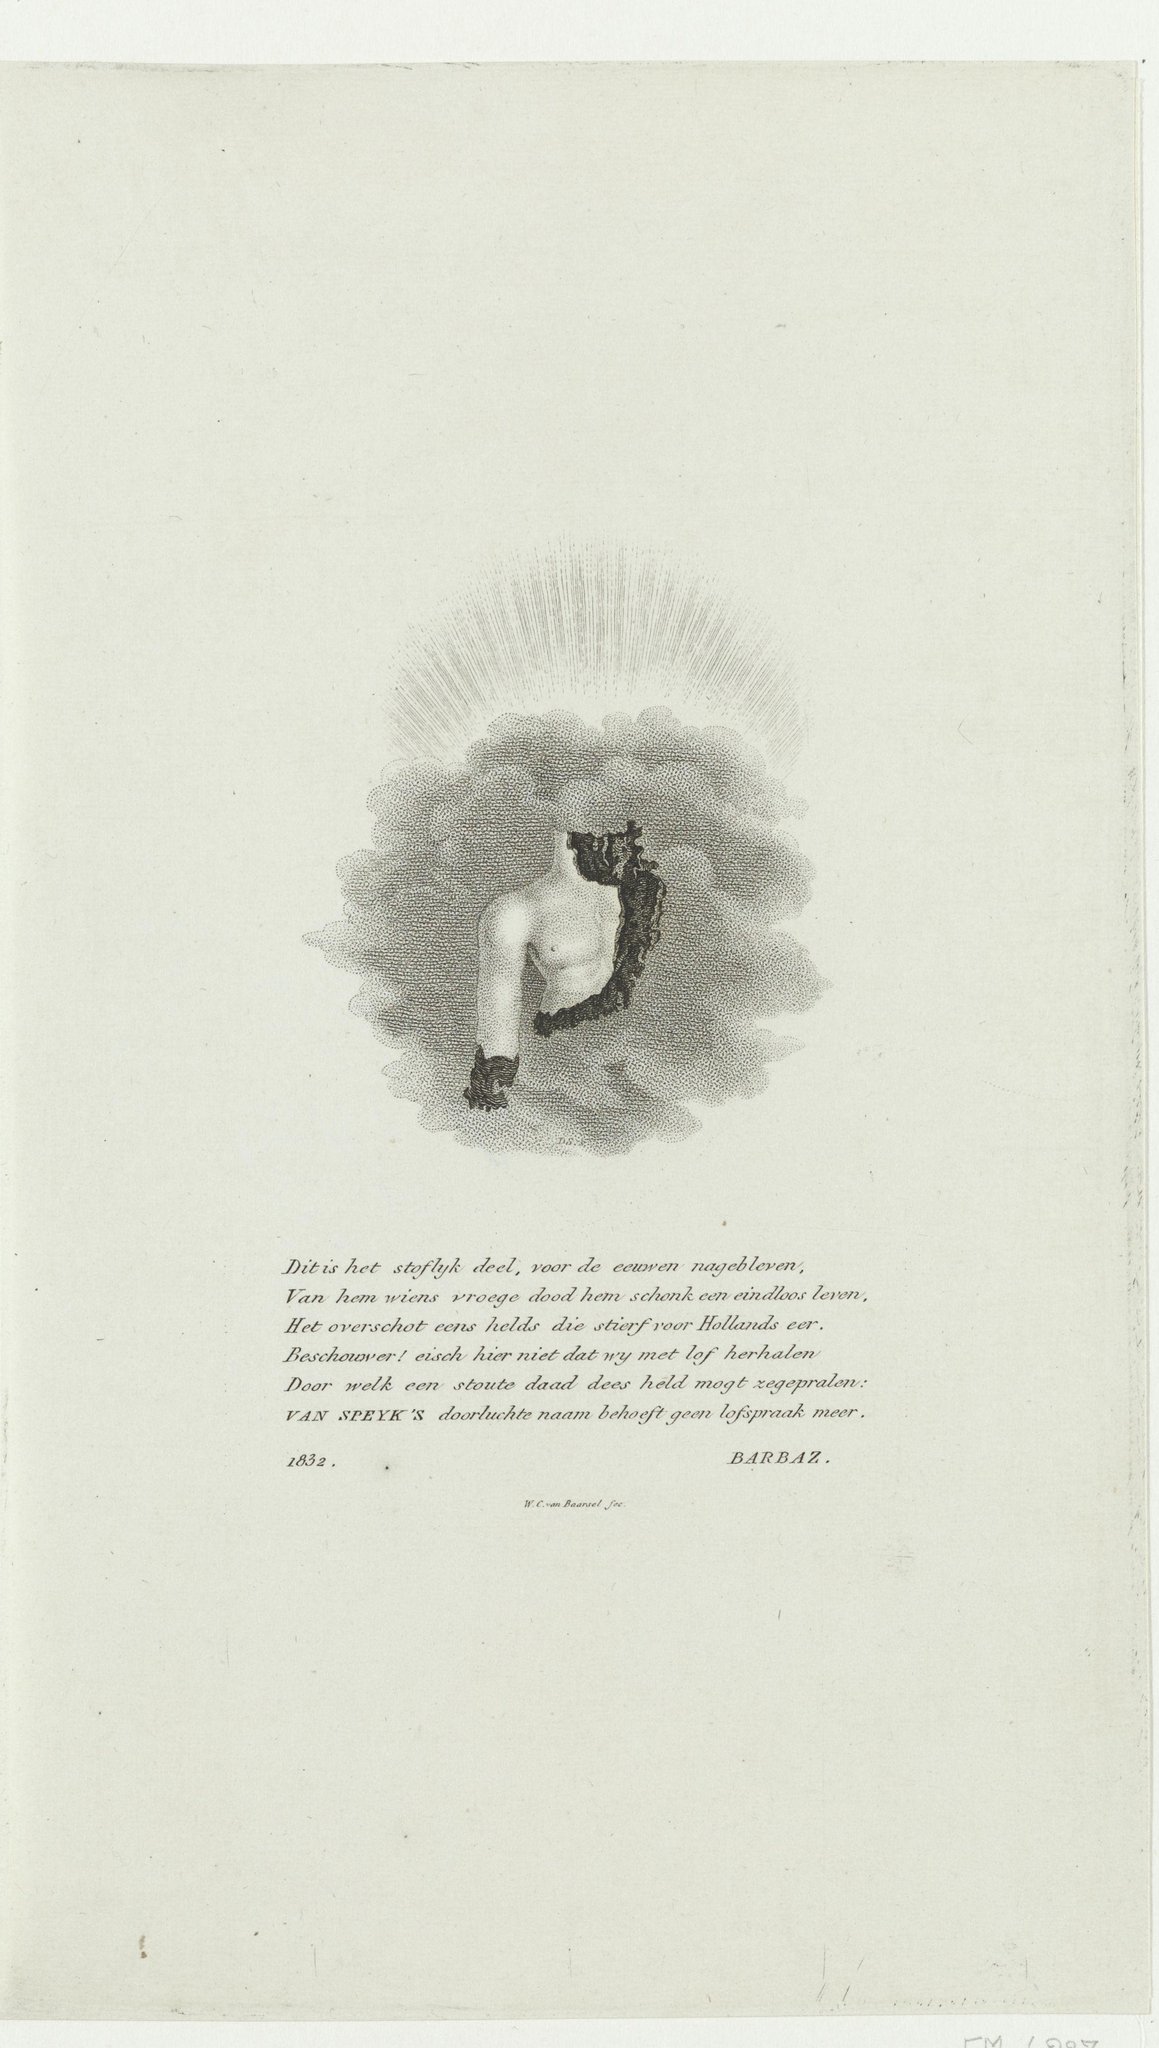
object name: print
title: Stoffelijk overschot van Jan van Speyk, 1832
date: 1832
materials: paper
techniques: engraving, etching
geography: netherlands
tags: amsterdam, antwerp, jan van speyk, shoulder, the corpse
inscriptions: collector's mark: Lugt 2228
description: Een deel van het stoffelijk overschot van Jan van Speyk. Een schouder met een stuk van de arm en borstkas. Voor een wolk met zonnestralen. Met zesregelig vers. Naar aanleiding van de begrafenis van de stoffelijke resten van Jan van Speyk en onthulling van het grafmonument in de Nieuwe Kerk te Amsterdam, 4 mei 1832